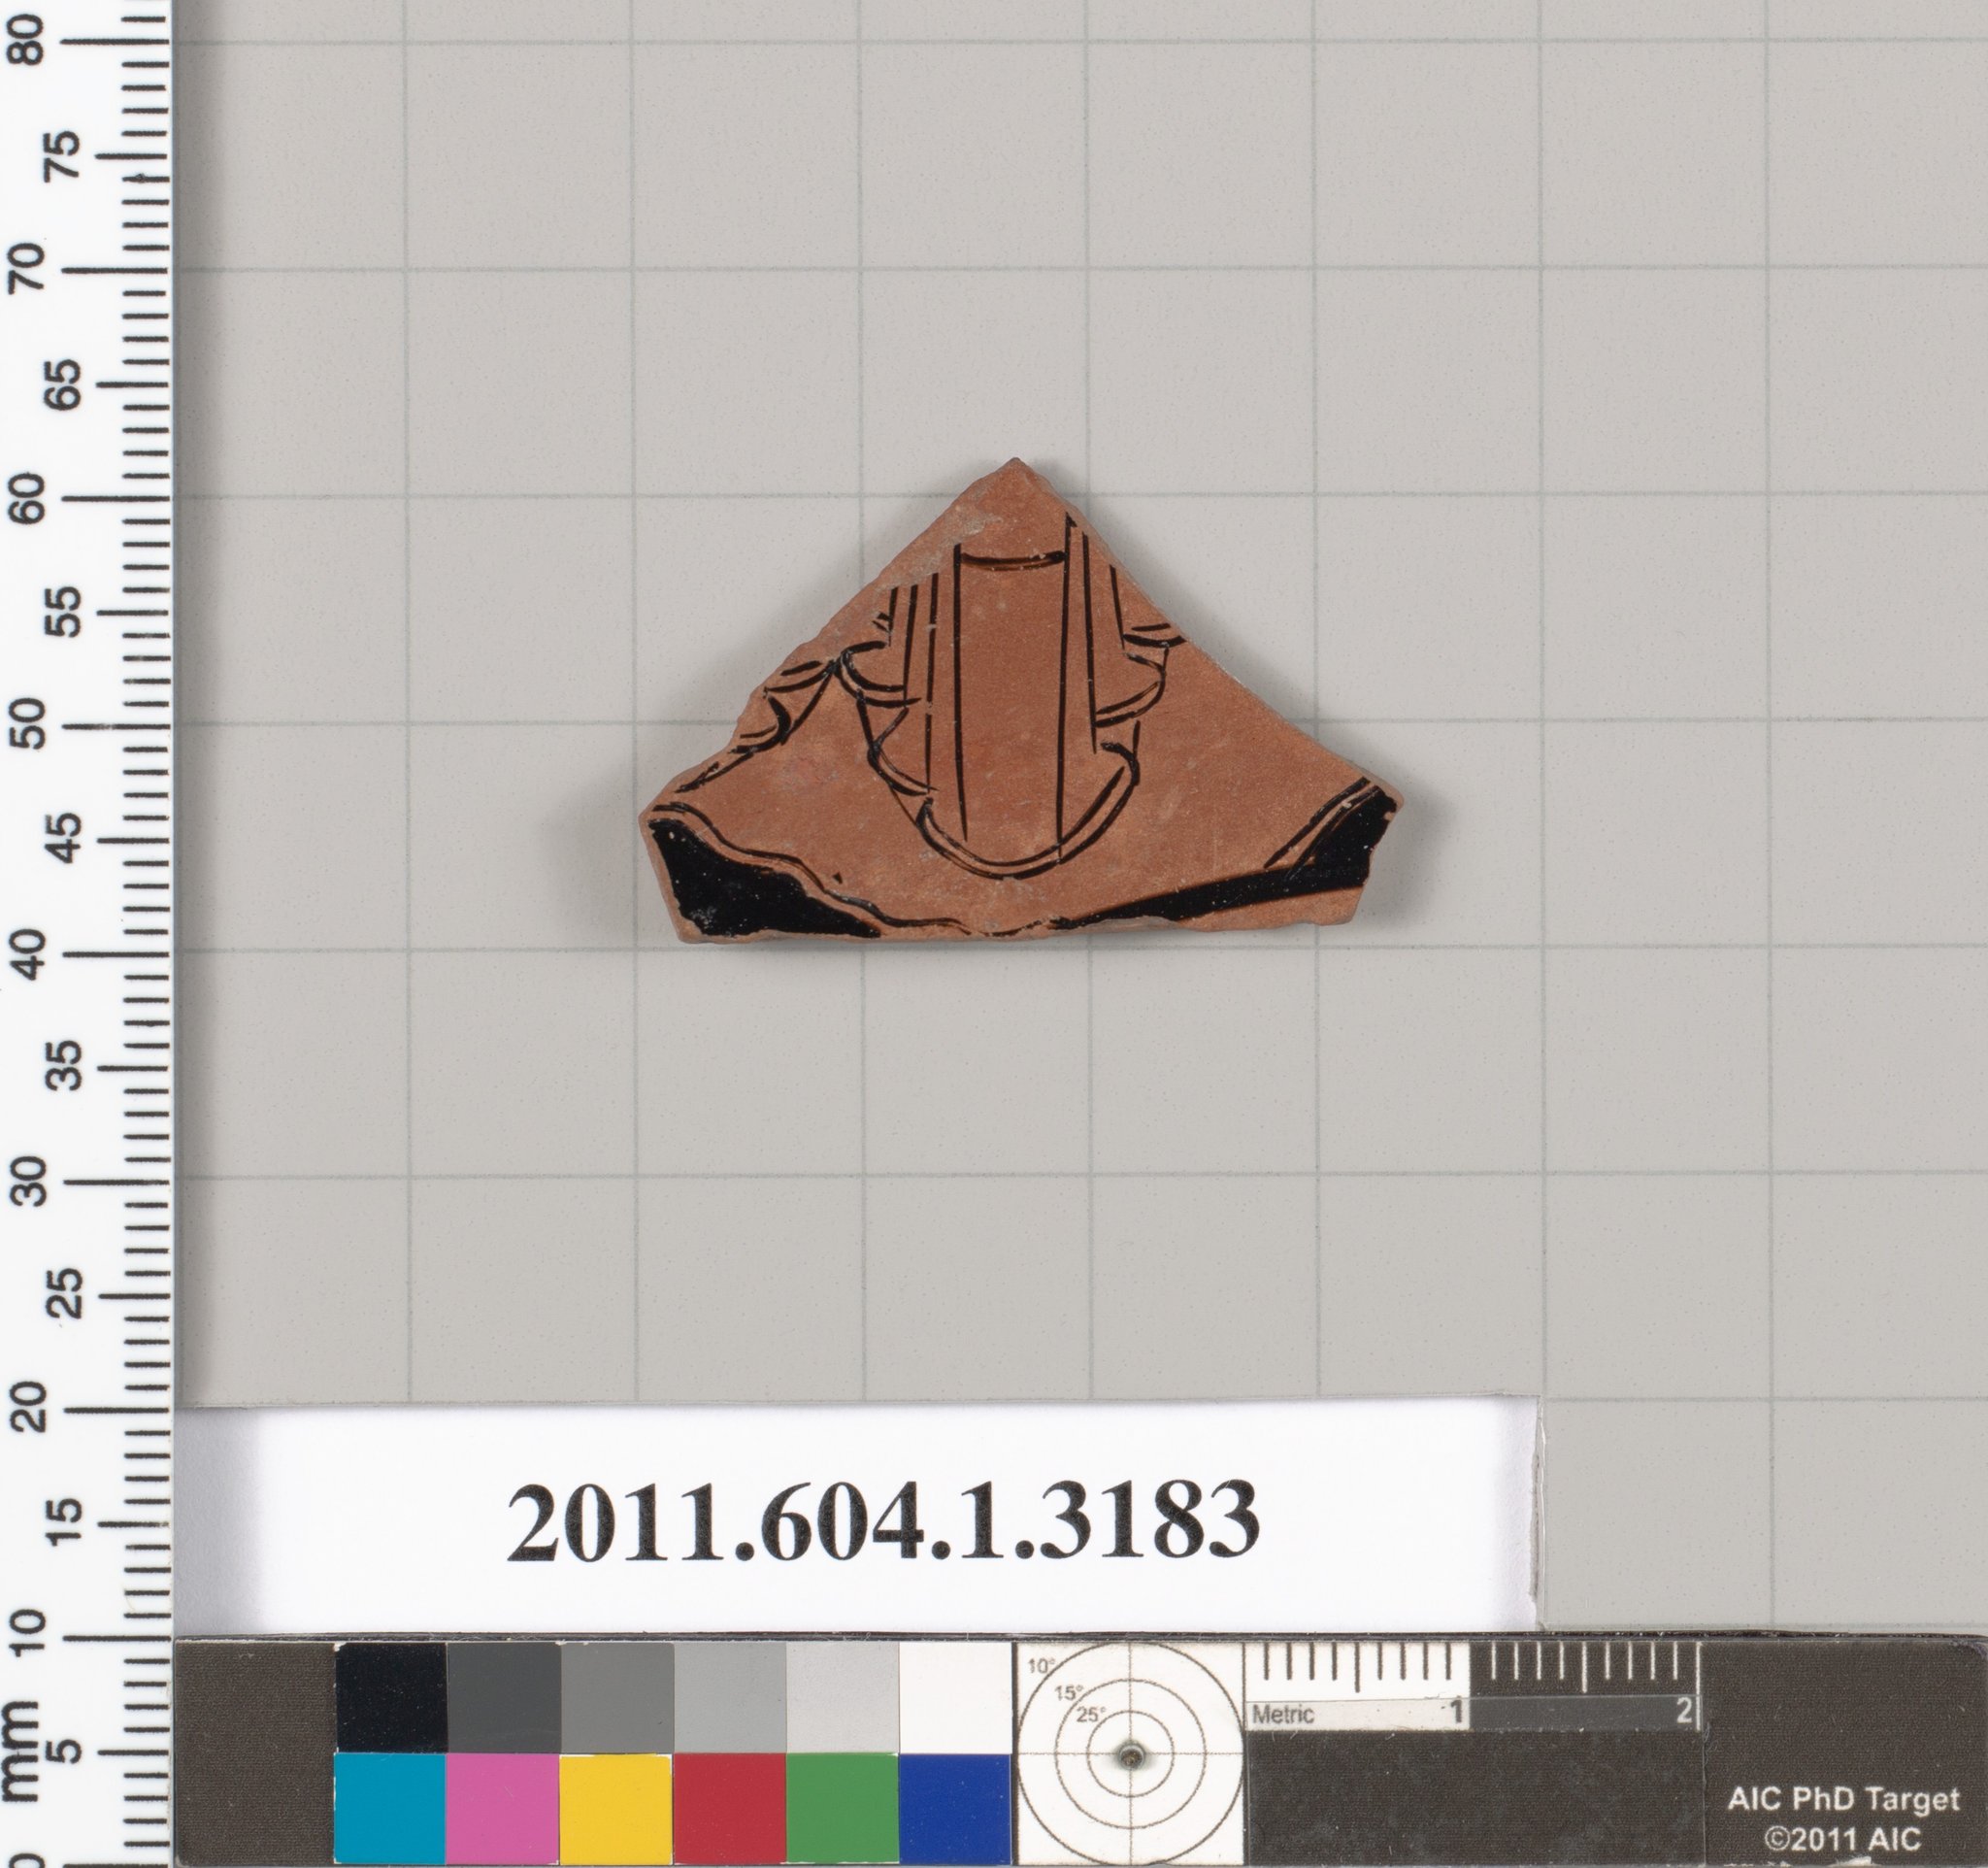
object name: kylix fragment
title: Terracotta fragment of a kylix (drinking cup)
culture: greek, attic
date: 490-480 BCE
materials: terracotta